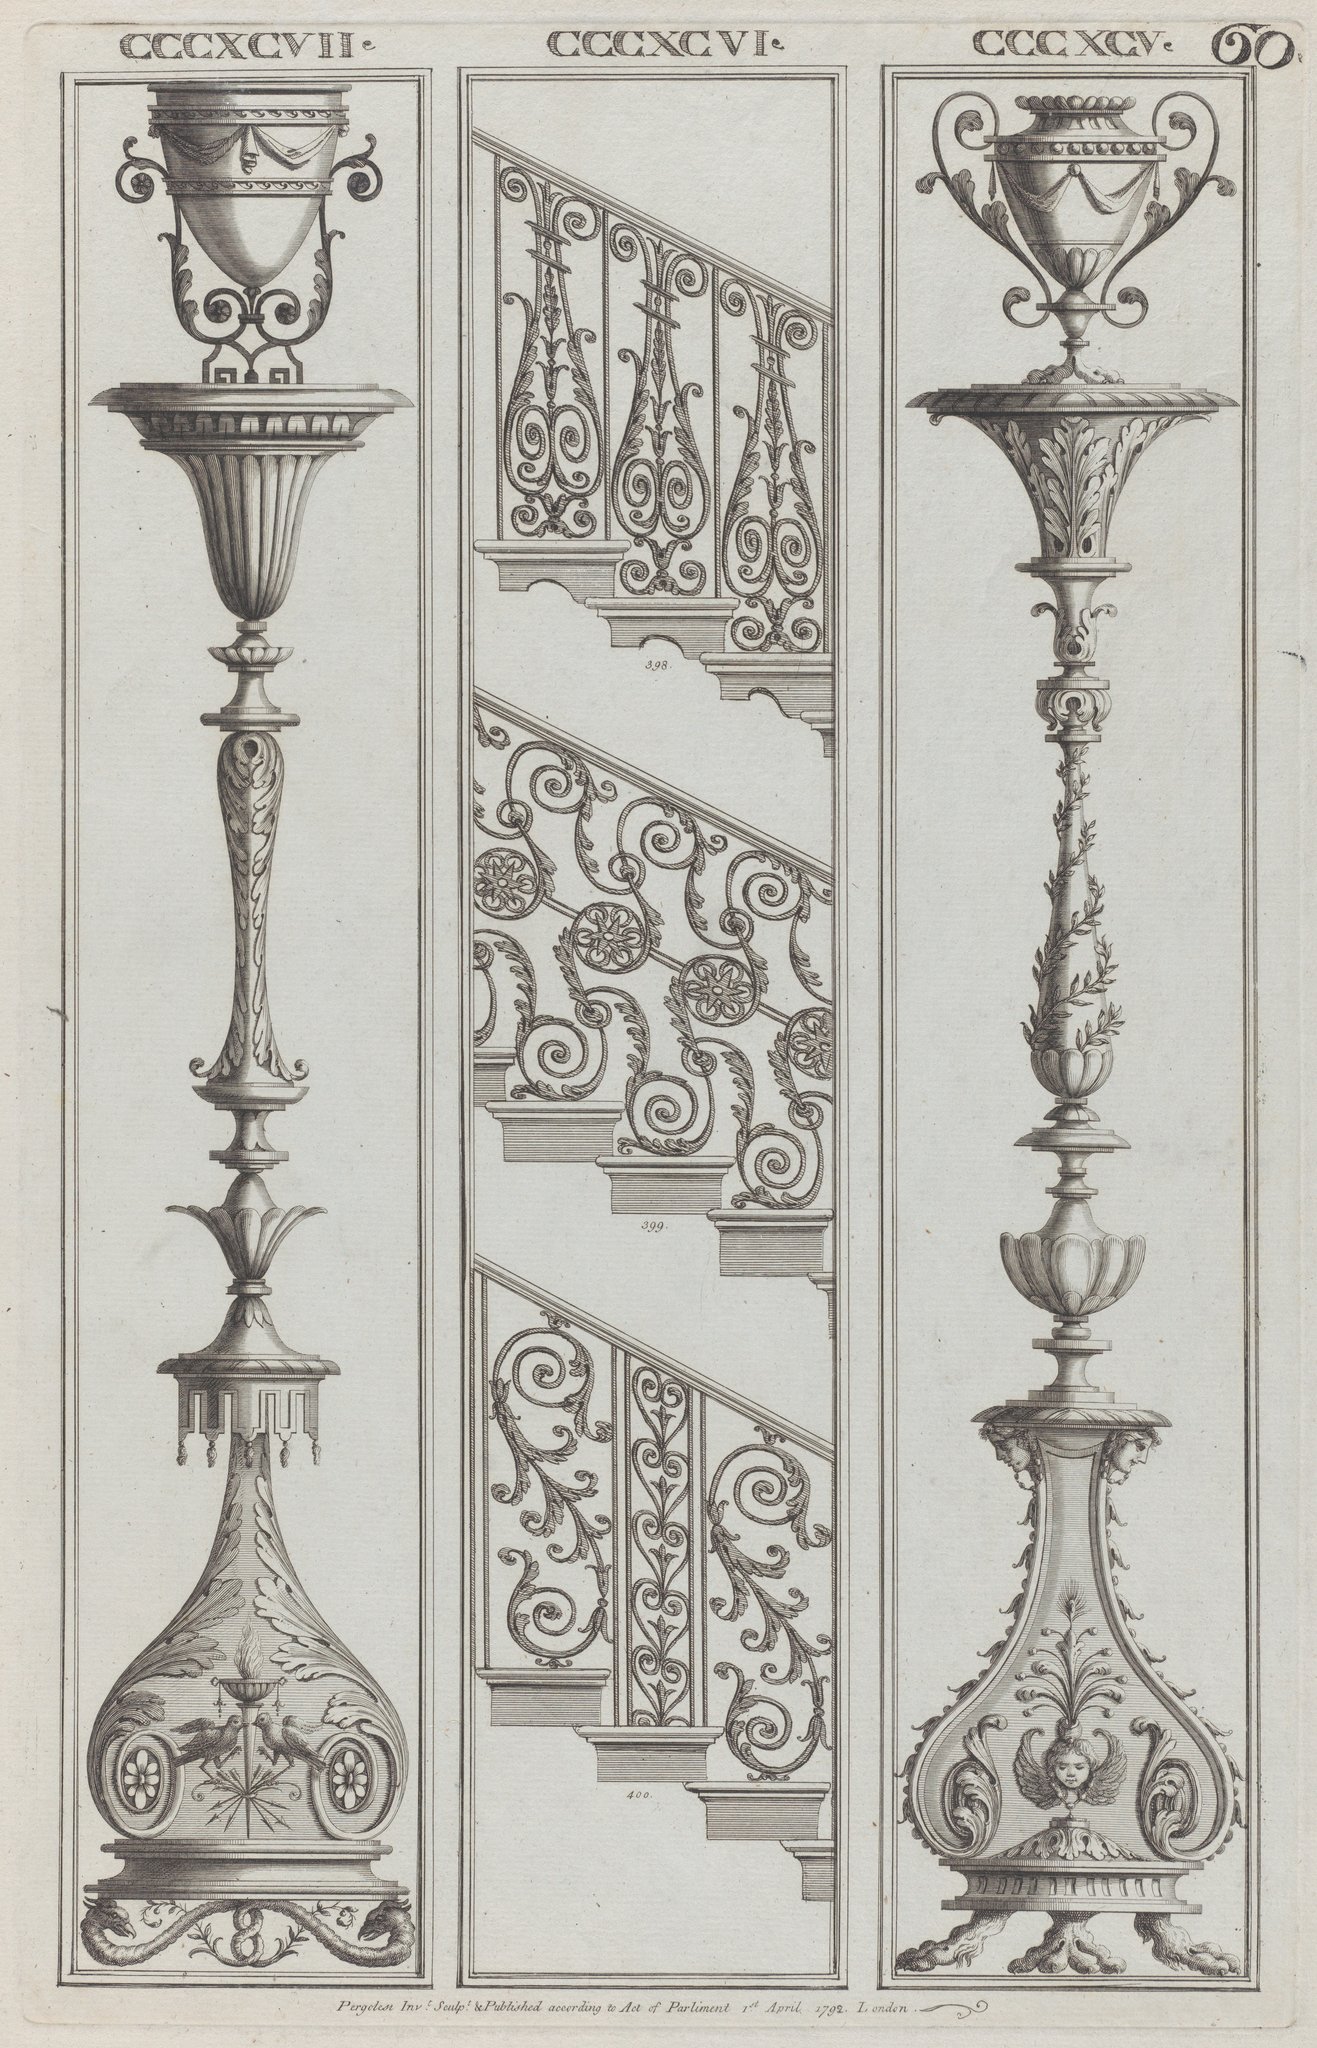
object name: print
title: Candelabra Designs and Stair Railing Designs, nos. CCCXCV–CCCXCVII and 398–400, plate 60 from "Designs for Various Ornaments"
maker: michelangelo pergolesi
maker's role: artist and publisher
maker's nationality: italian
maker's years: 1760-1801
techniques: etching